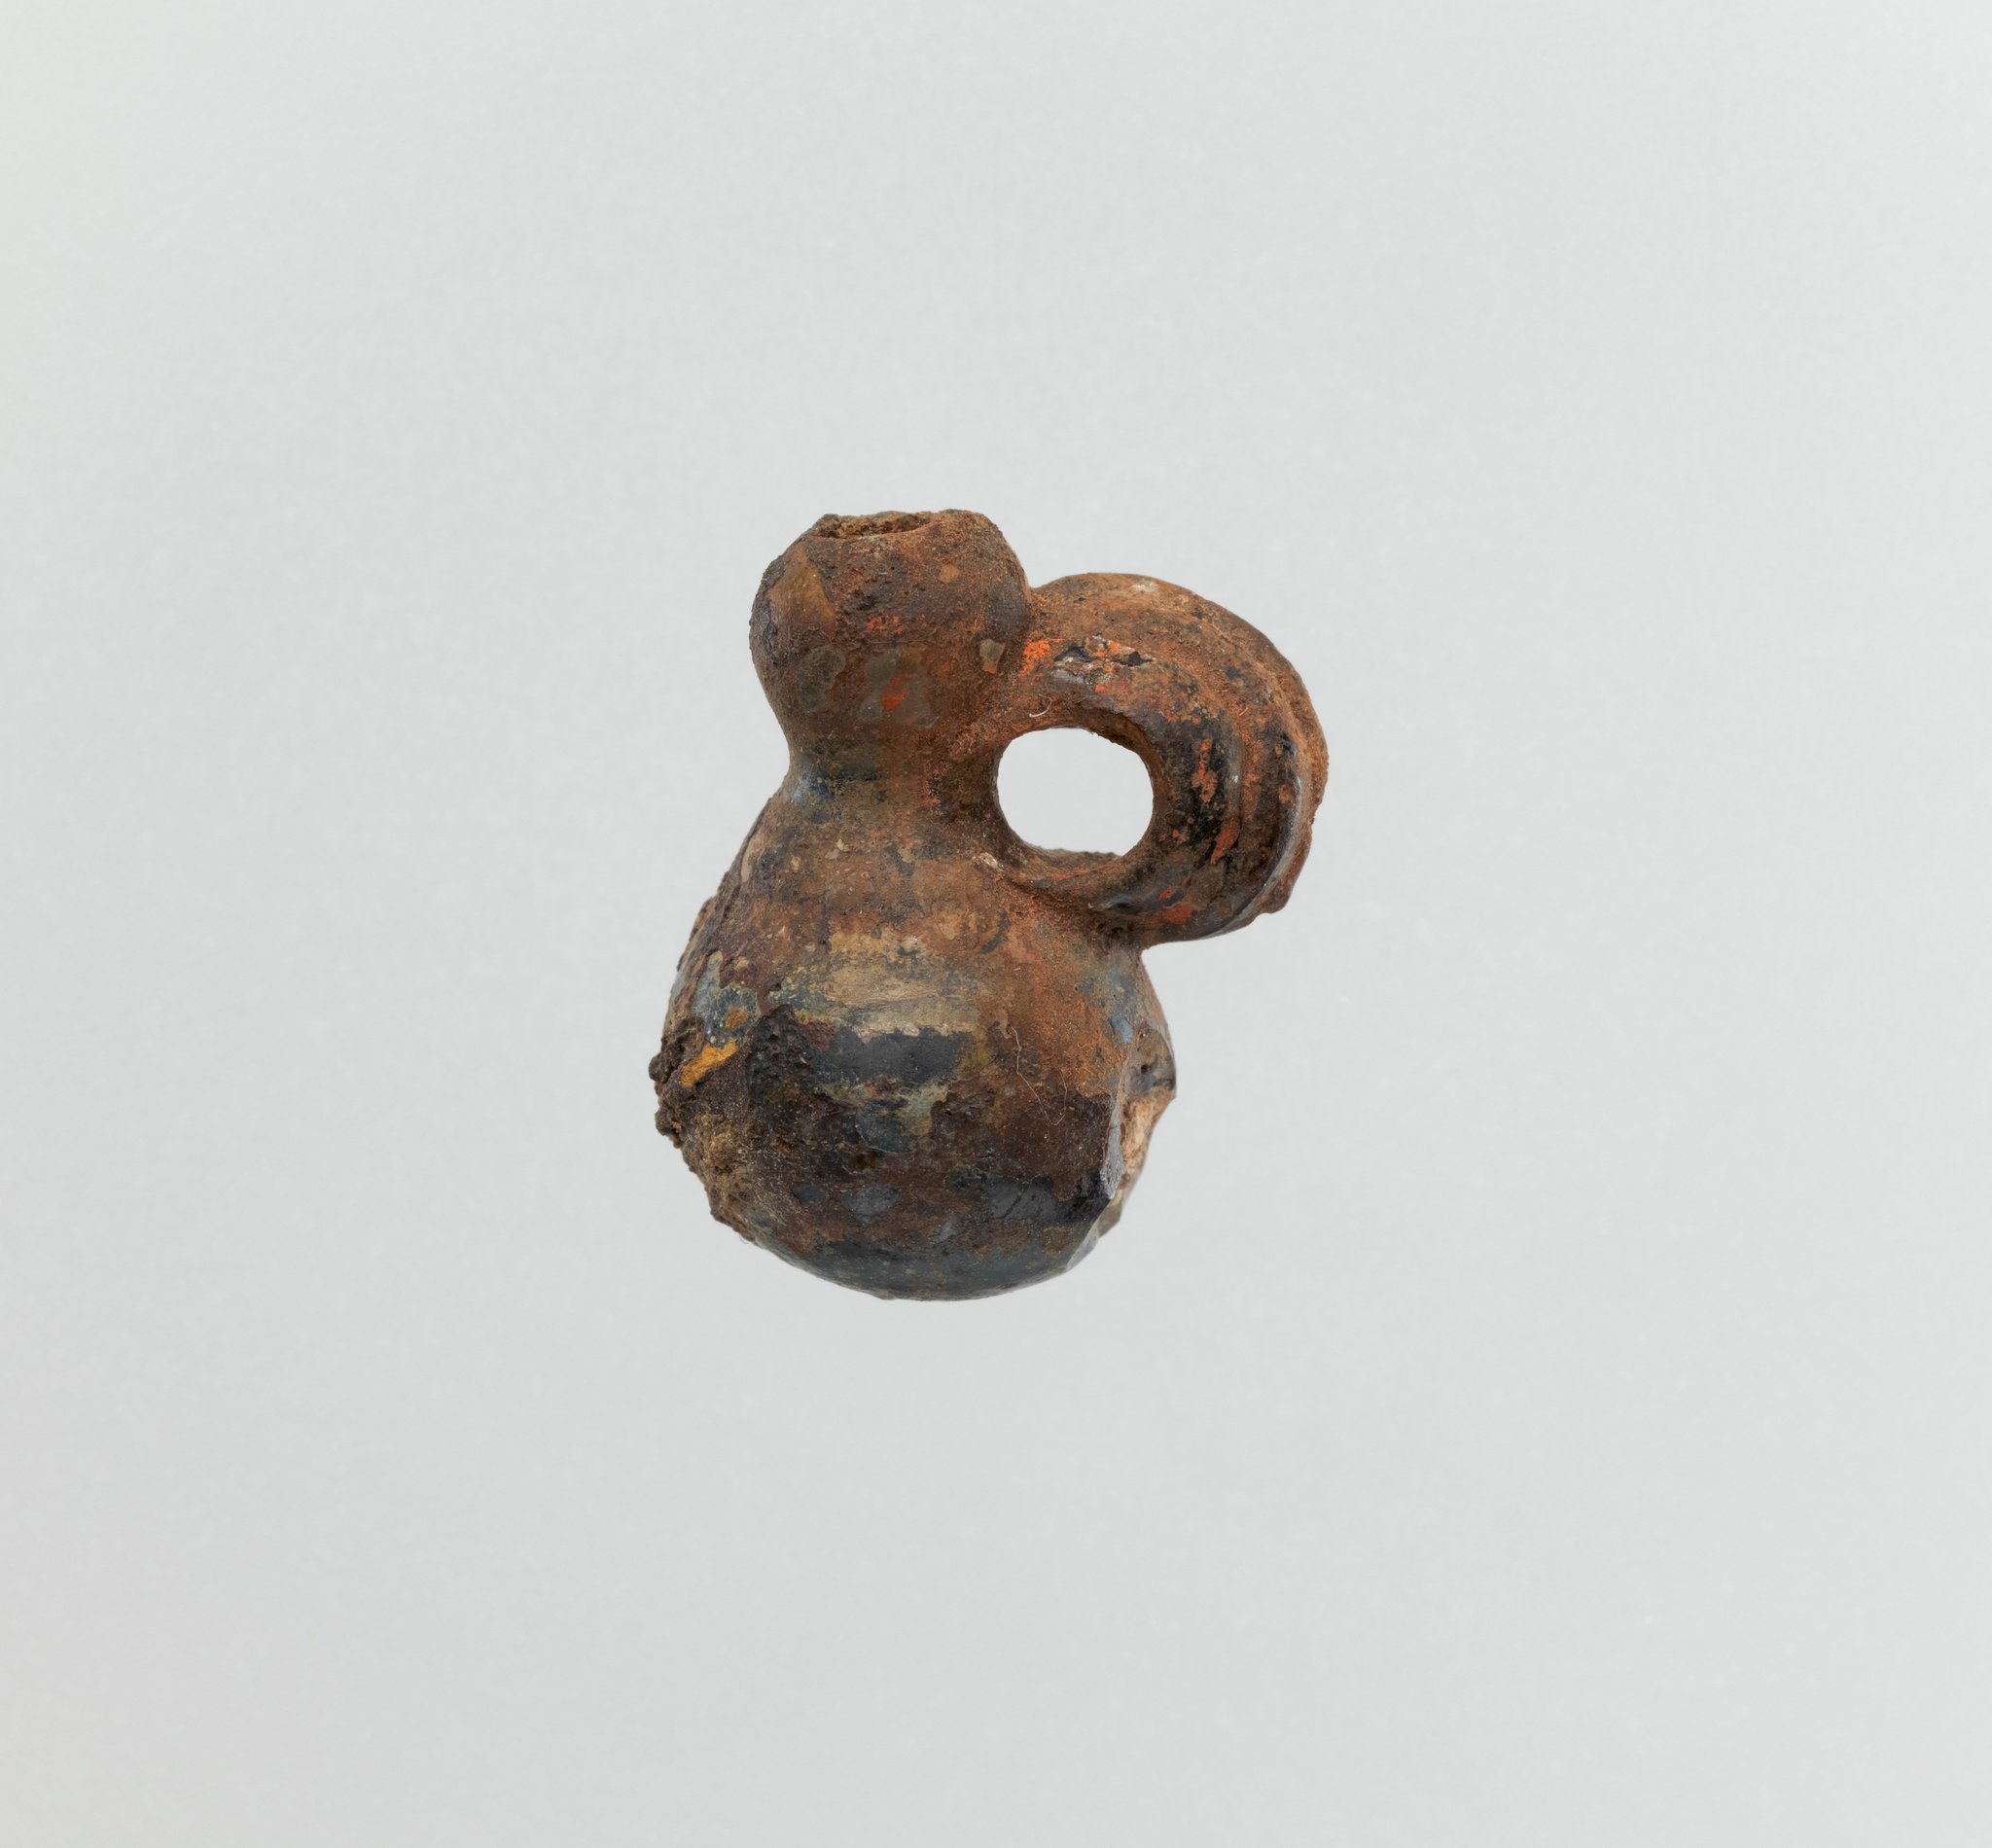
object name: pendant in the form of a jug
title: Glass pendant in the form of a miniature jug or gourd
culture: roman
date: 301-500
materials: glass